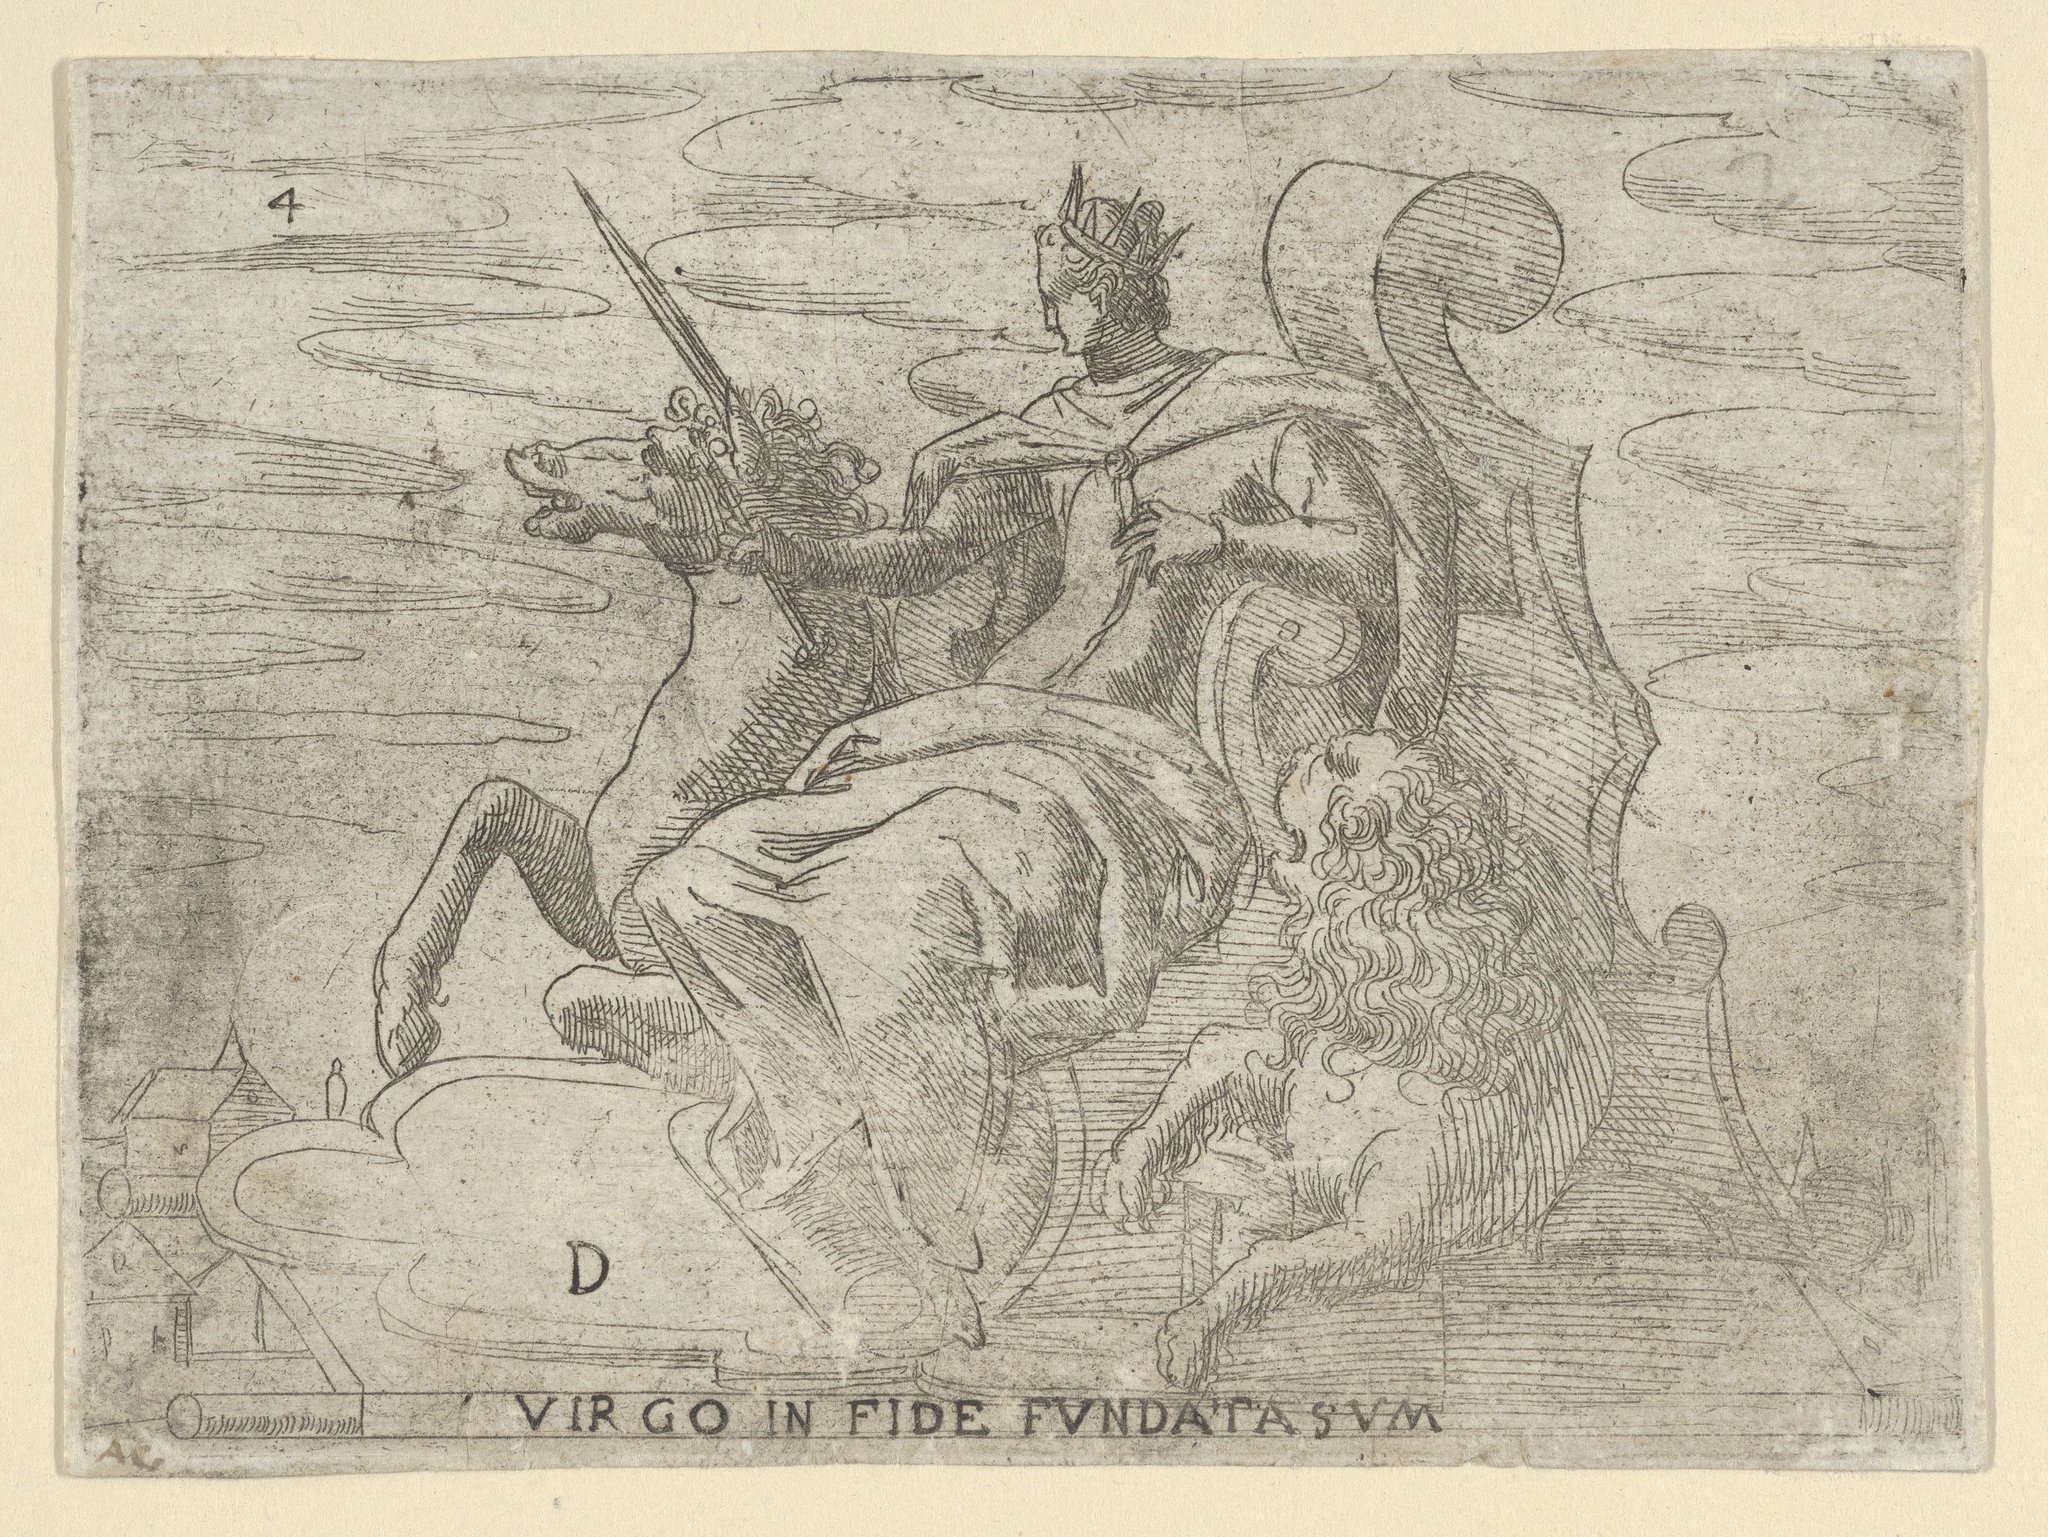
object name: print, fete, ornament architecture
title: Virgo in Fide Fundata Sum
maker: anonymous, italian, 16th century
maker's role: artist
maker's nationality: italian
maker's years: 1500-1600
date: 1501-1600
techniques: etching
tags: men,unicorns,lions